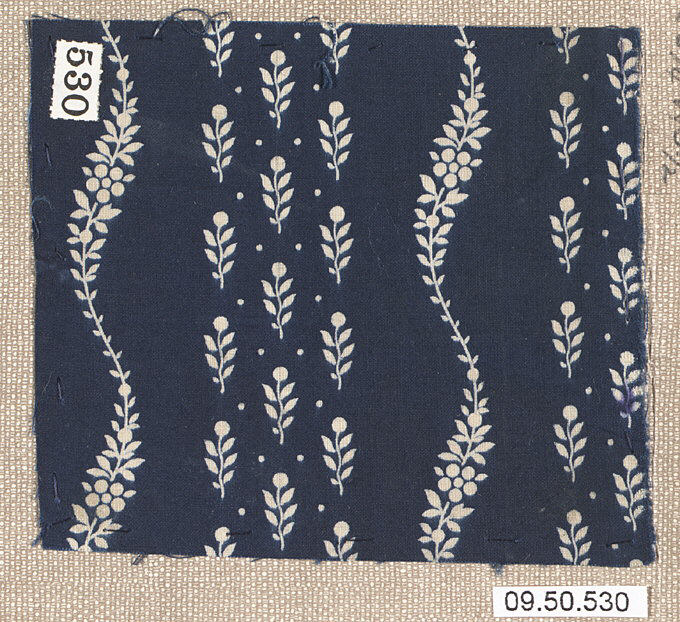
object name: piece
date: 1801-1900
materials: cotton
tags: flowers,leaves